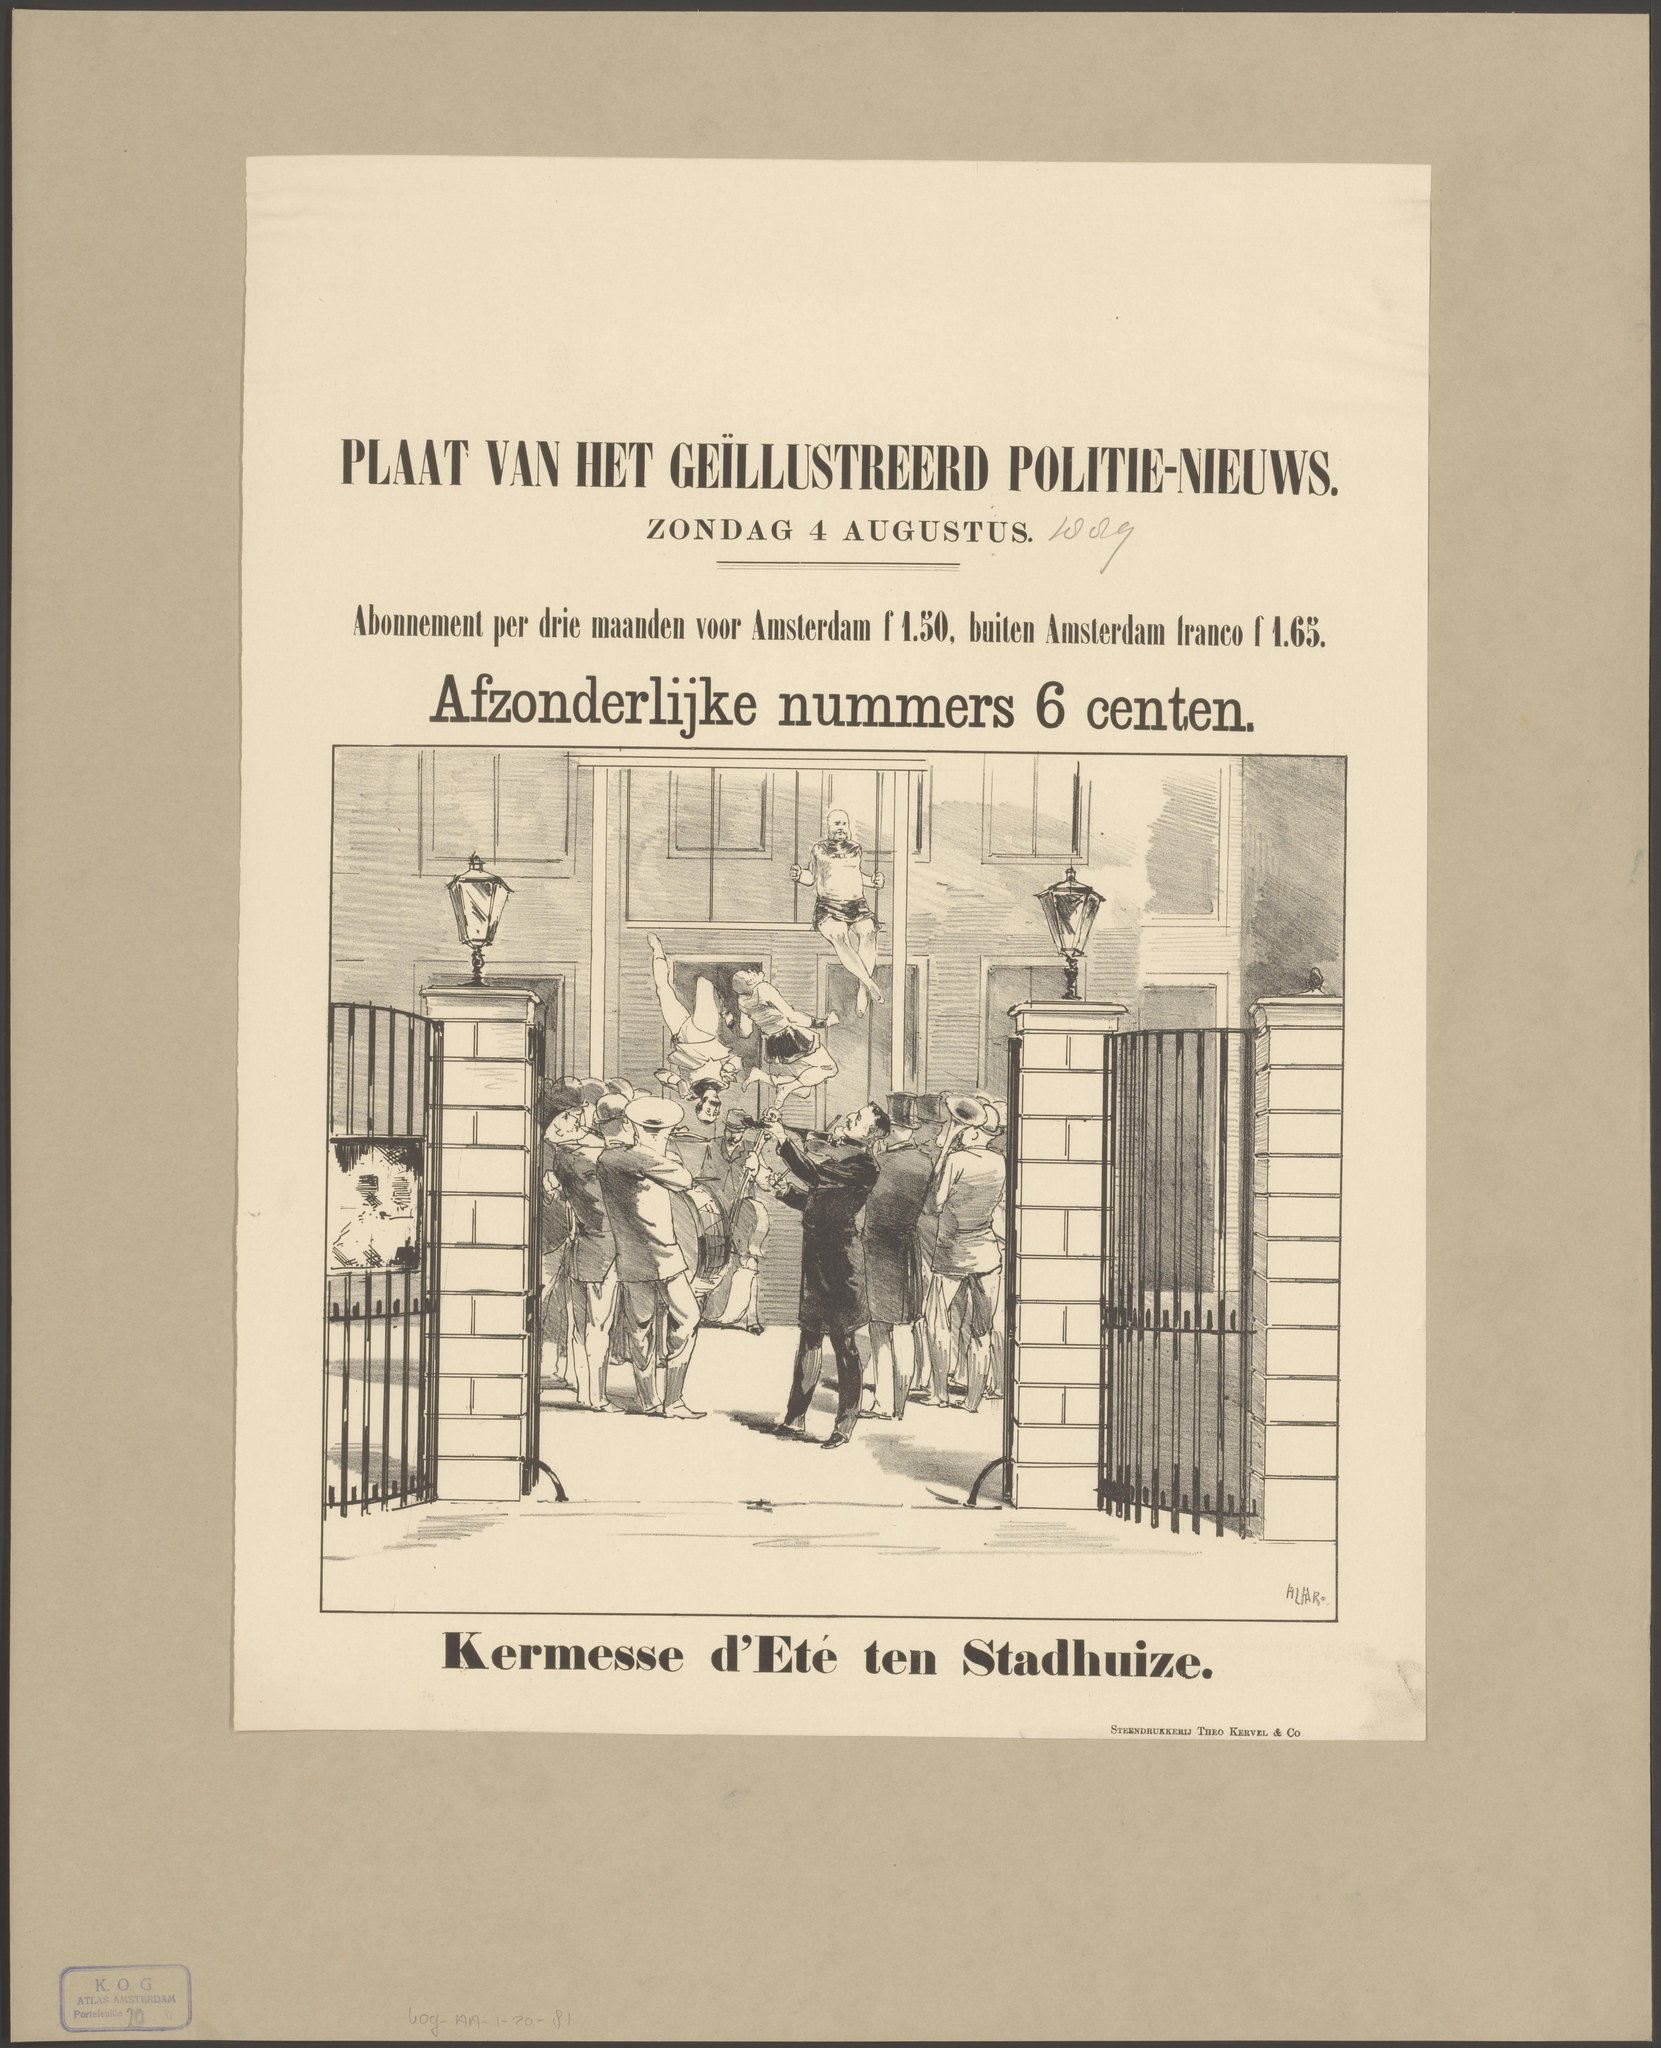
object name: cartoon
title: Kermesse d'Eté ten Stadhuize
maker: alfaro reijding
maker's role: draughtsman, engineer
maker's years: 1863-1930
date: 1889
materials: paper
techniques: letterpress printing, lithograph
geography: amsterdam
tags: musician, acrobat ~ circus, political caricatures and satires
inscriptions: collector's mark: Lugt 1641b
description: Gepubliceerd als bijvoegsel van 'Geïllustreerd Politie-Nieuws', 4 augustus 1889.